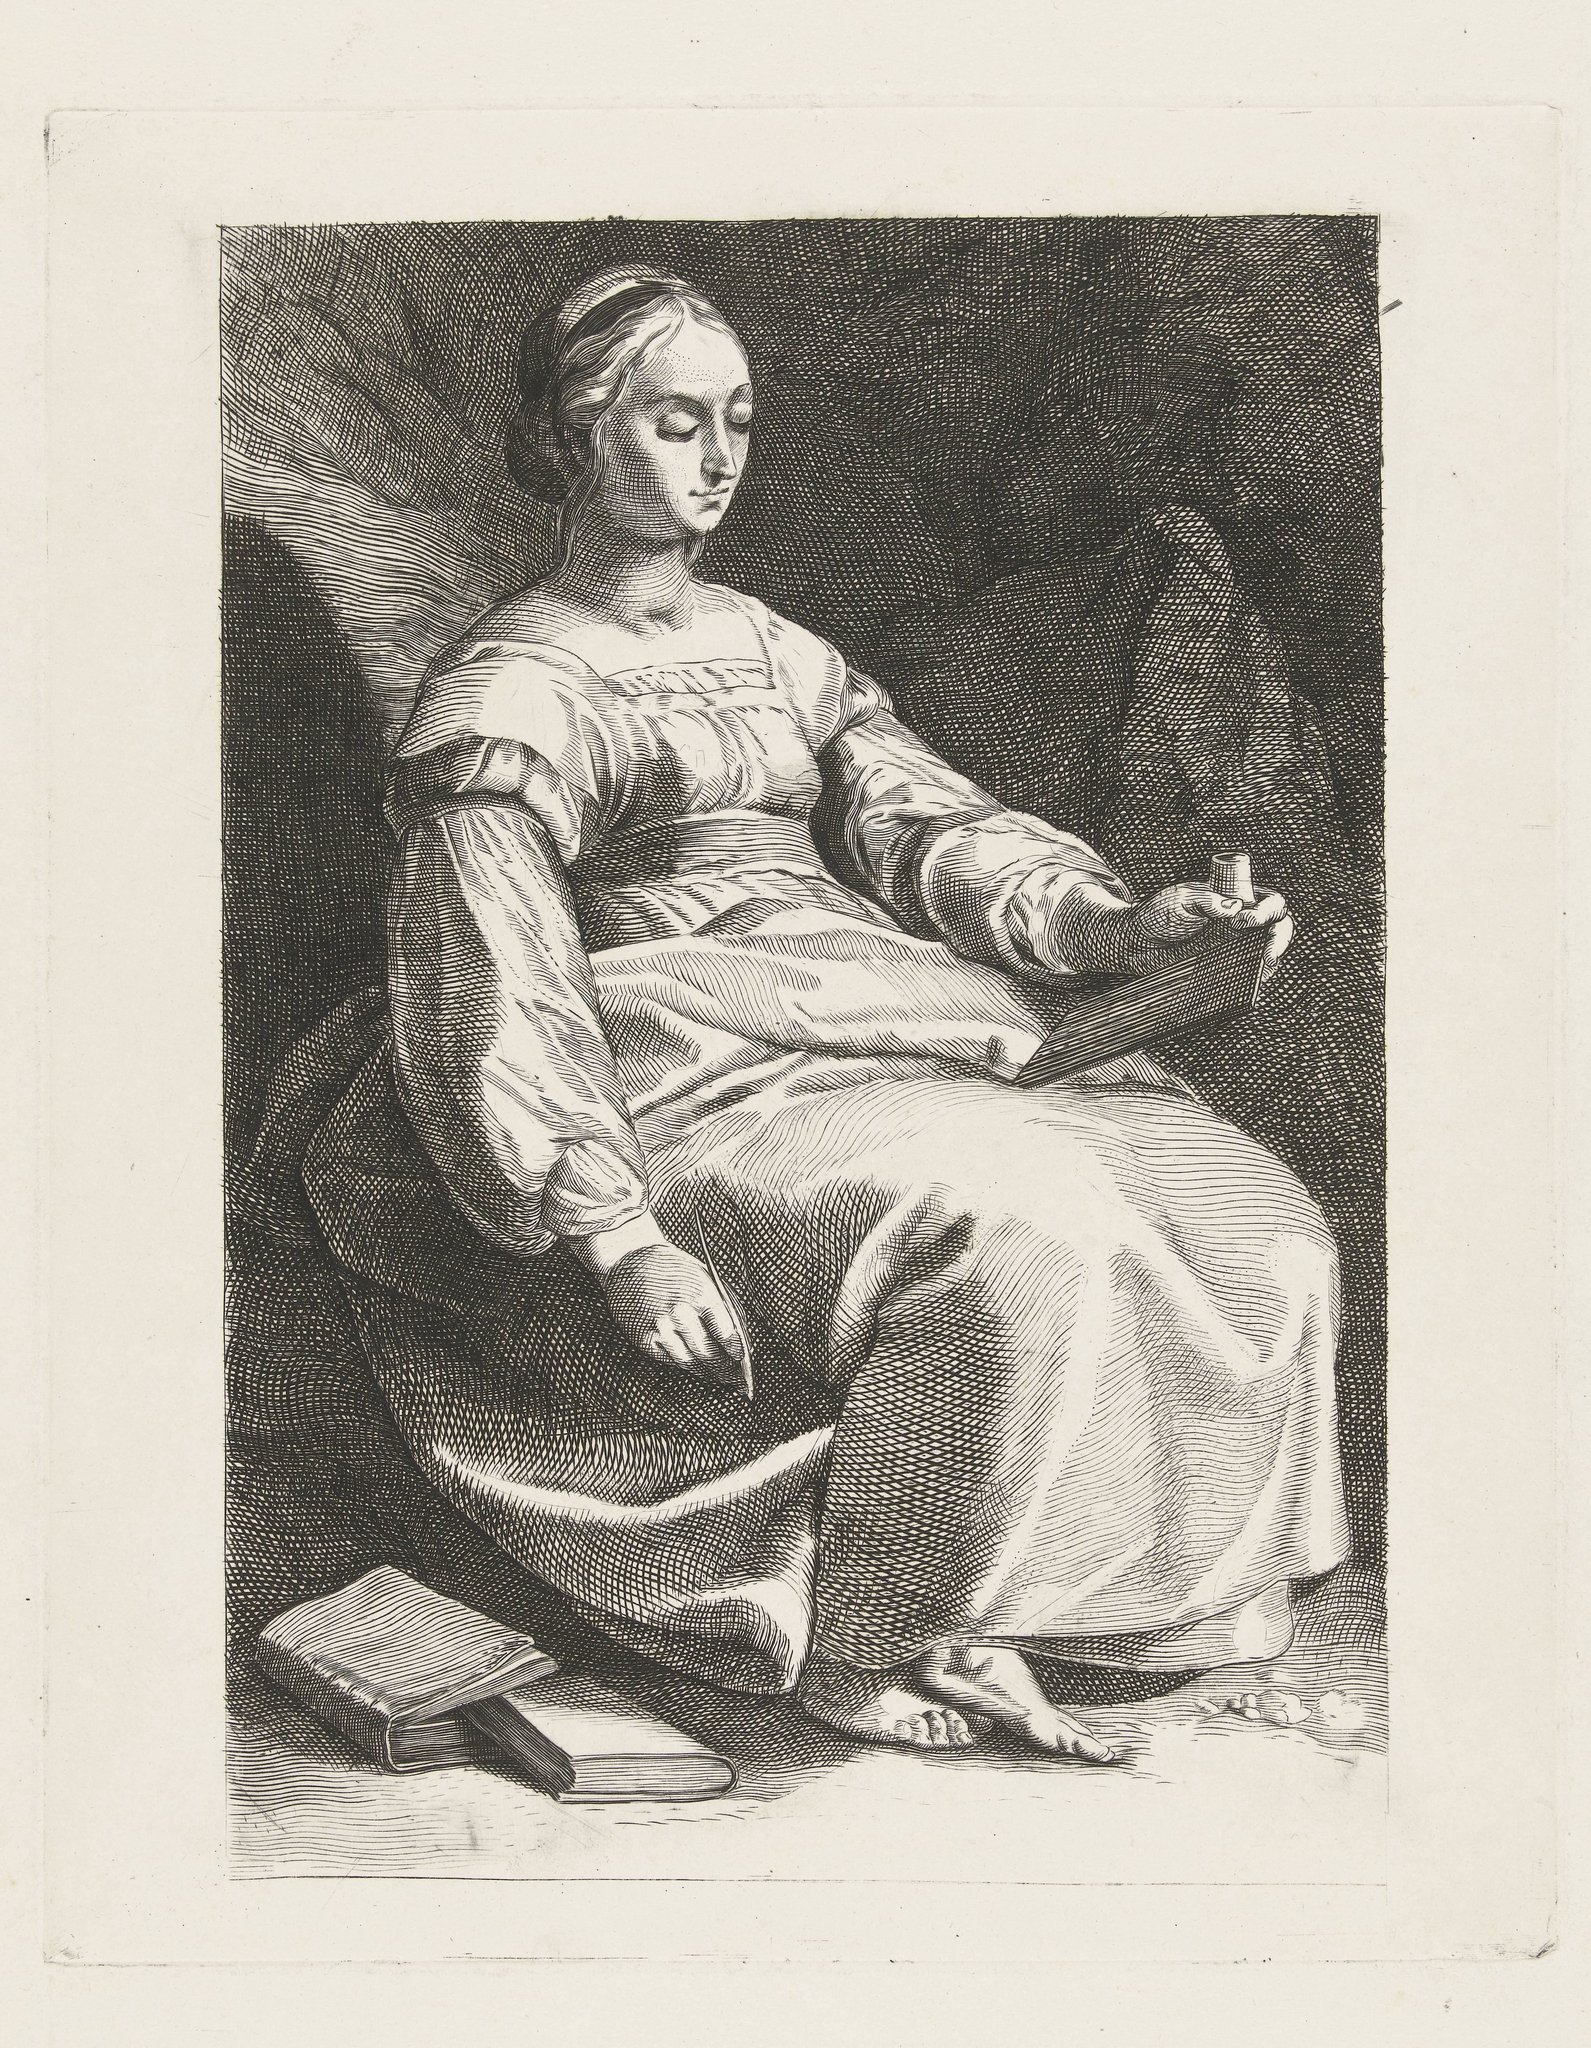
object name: print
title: Clio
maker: petrus johannes arendzen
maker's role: draughtsman, print maker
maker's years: 1846-1932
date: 1863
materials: paper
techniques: engraving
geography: netherlands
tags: clio (one of the muses); 'clio' (ripa)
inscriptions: inscription: ‘PJ Arendzen 12 Sept 1863’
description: kopie naar H. Goltzius, Bartsch 149/Hollstein 151